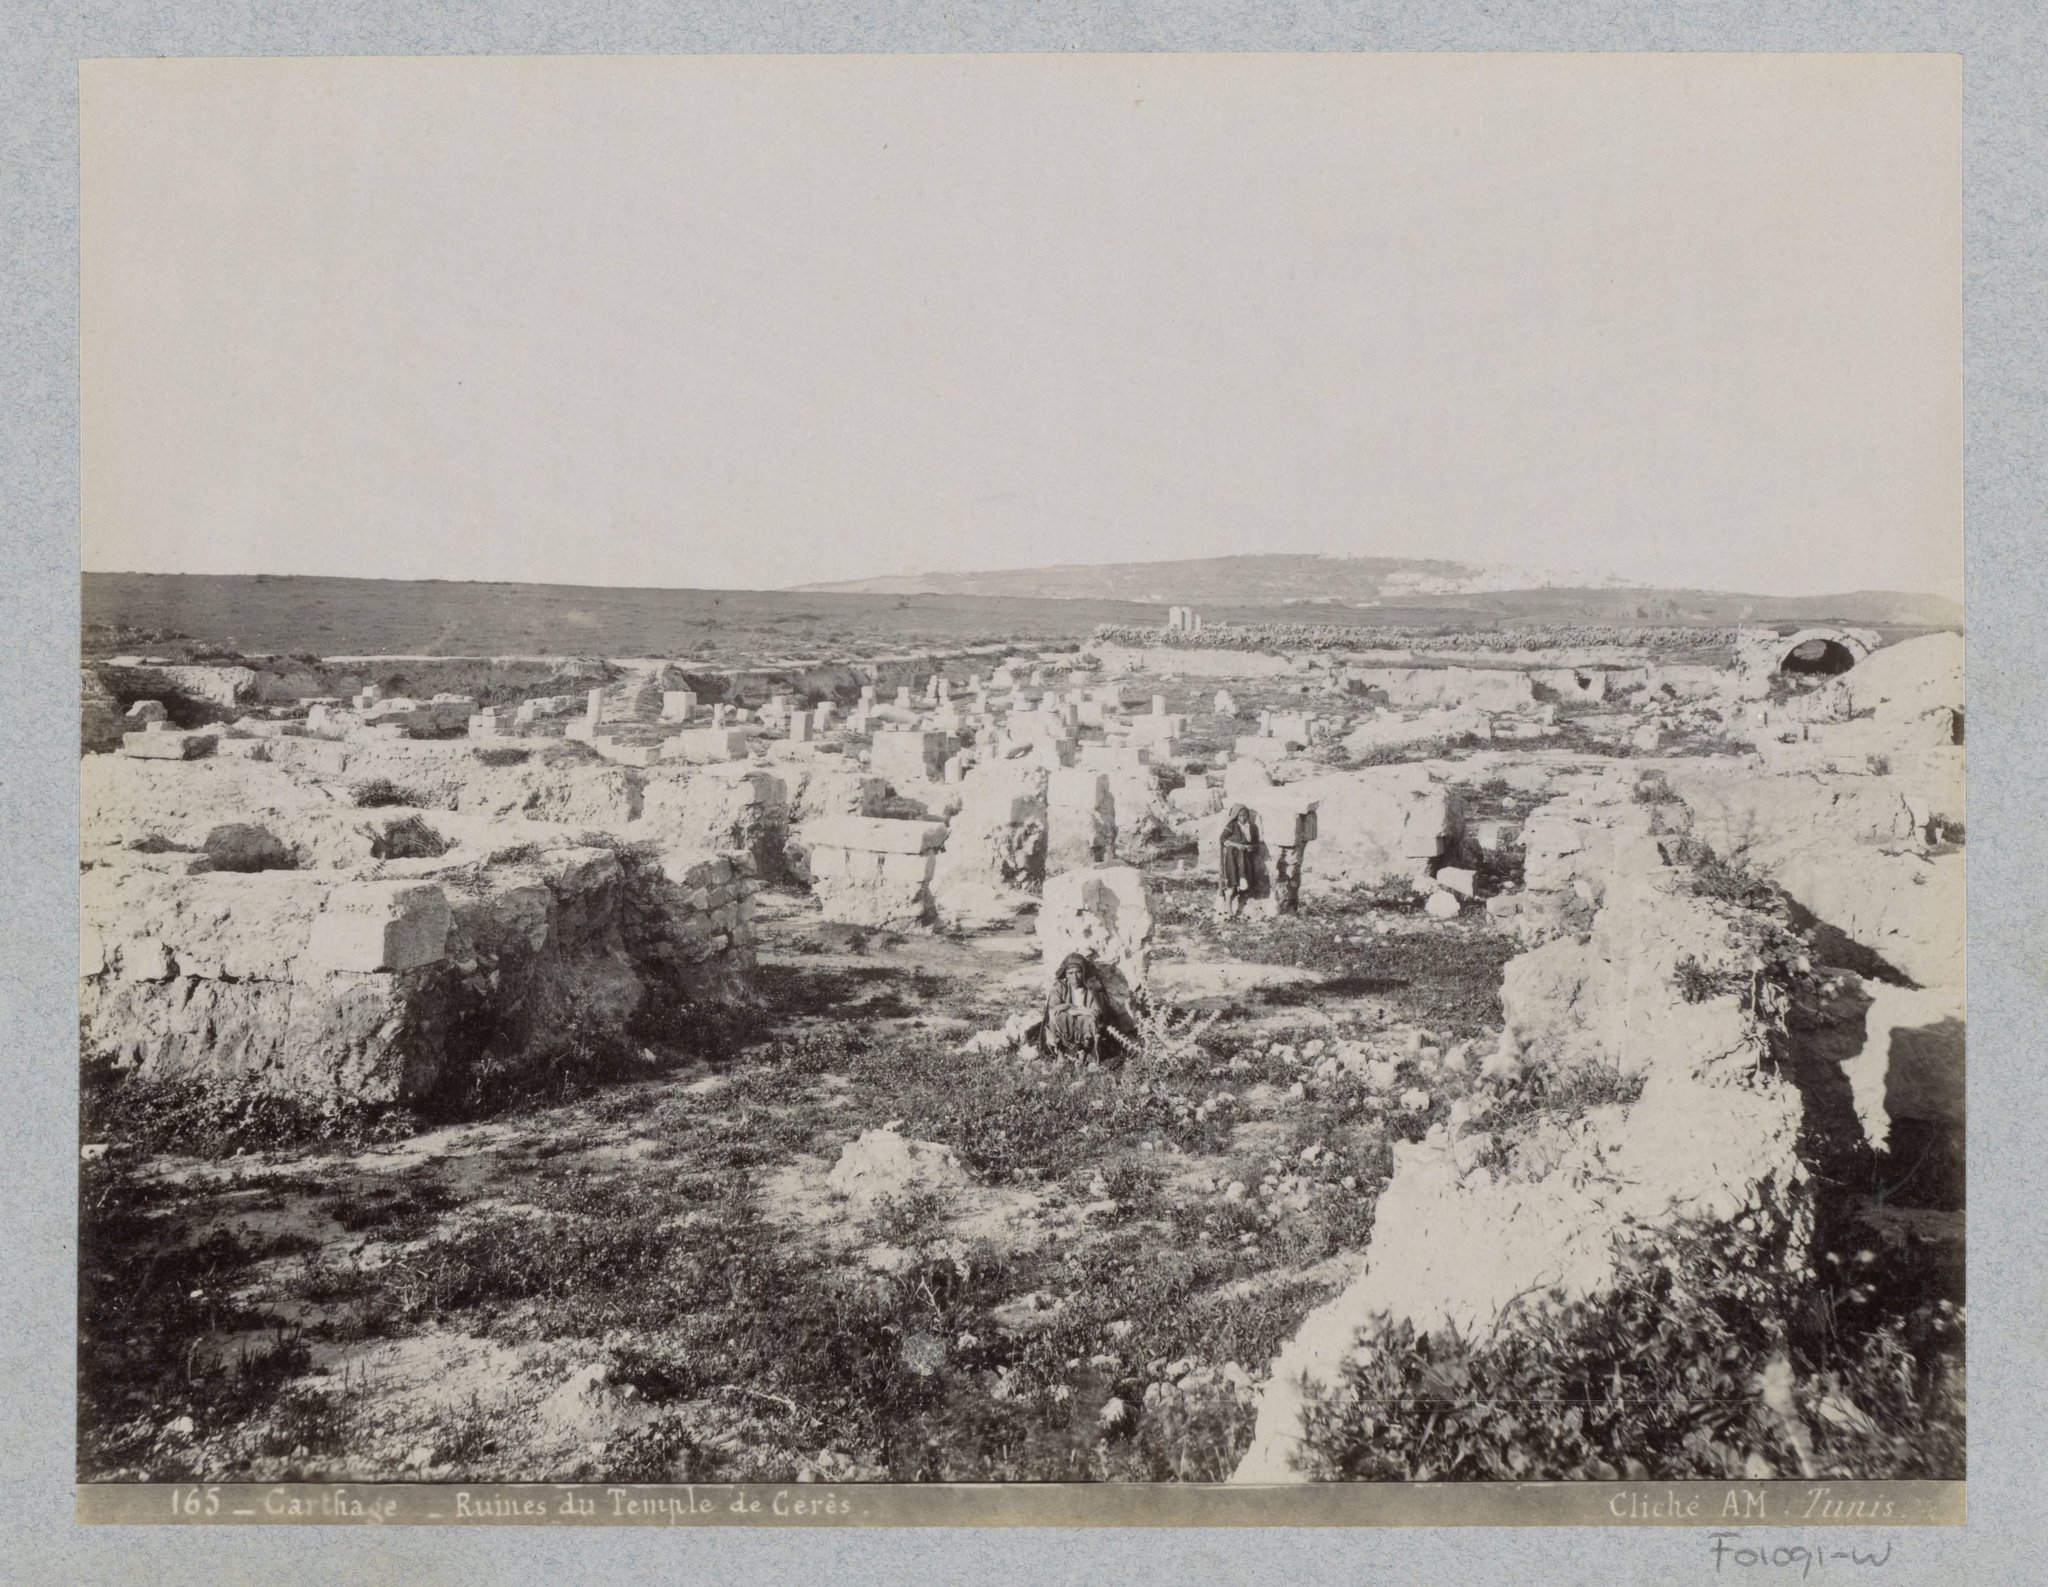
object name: photograph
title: Gezicht op de ruïnes van de Tempel van Ceres in Carthago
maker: am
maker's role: fotograaf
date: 1880-1900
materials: paper, photographic support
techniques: albumen print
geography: carthage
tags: landscape with ruins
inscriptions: negative number: ‘165’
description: Onderdeel van Reisalbum met foto's van bezienswaardigheden in Tunis en Tunesië.